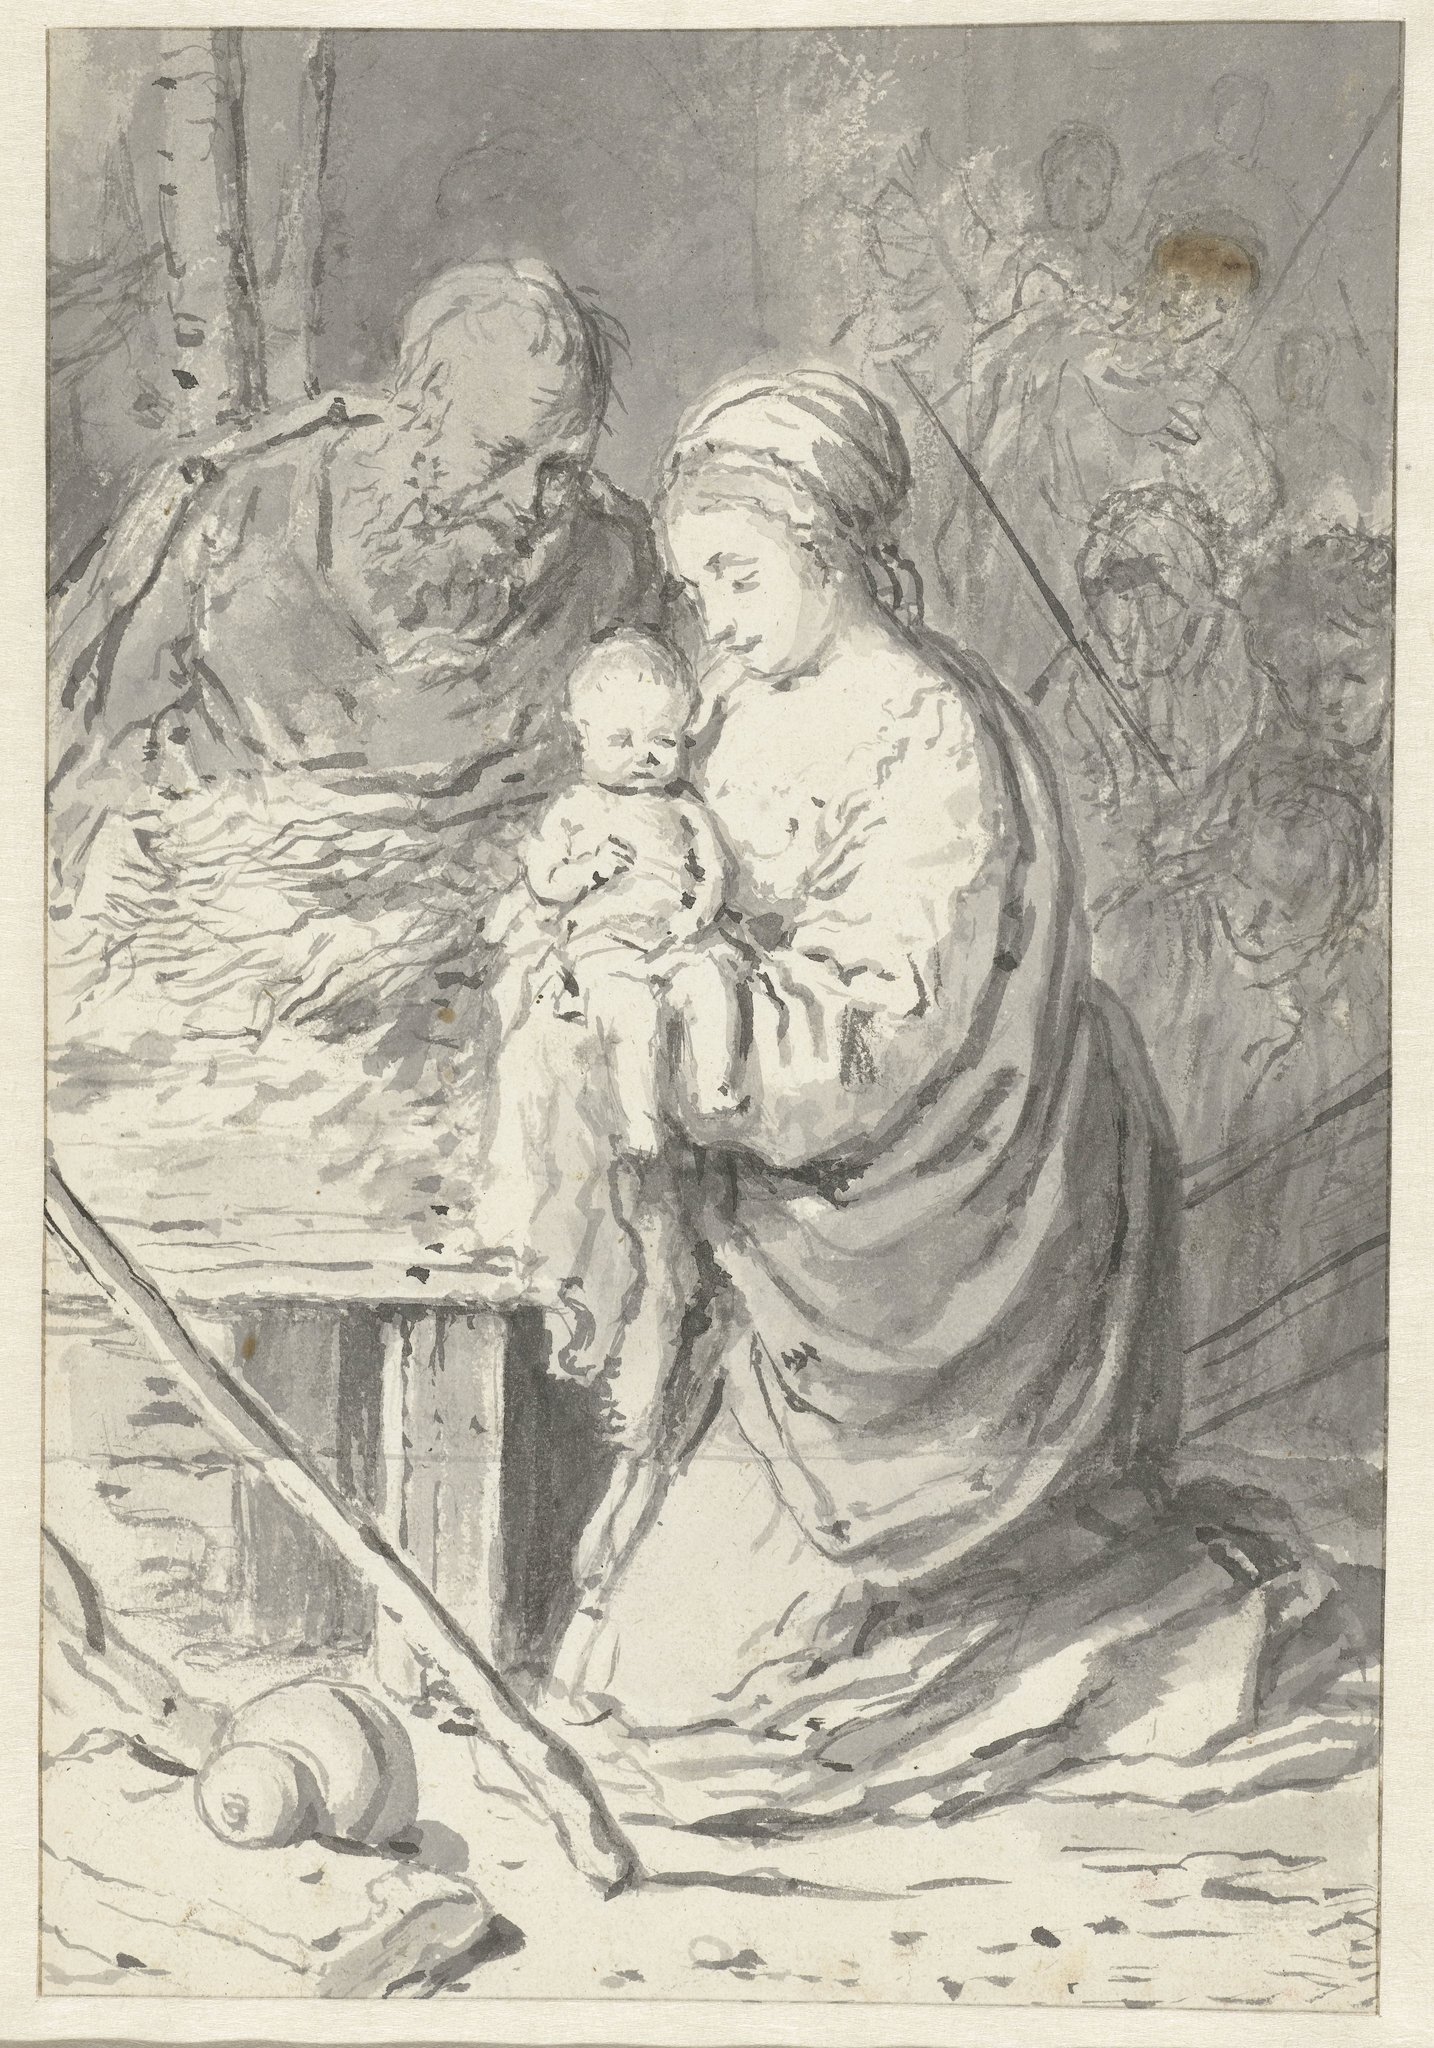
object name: drawing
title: De Heilige Familie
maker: willem strijcker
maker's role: draughtsman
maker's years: 1606-1677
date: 1600-1699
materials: paper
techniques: brush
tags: holy family, and derived representations